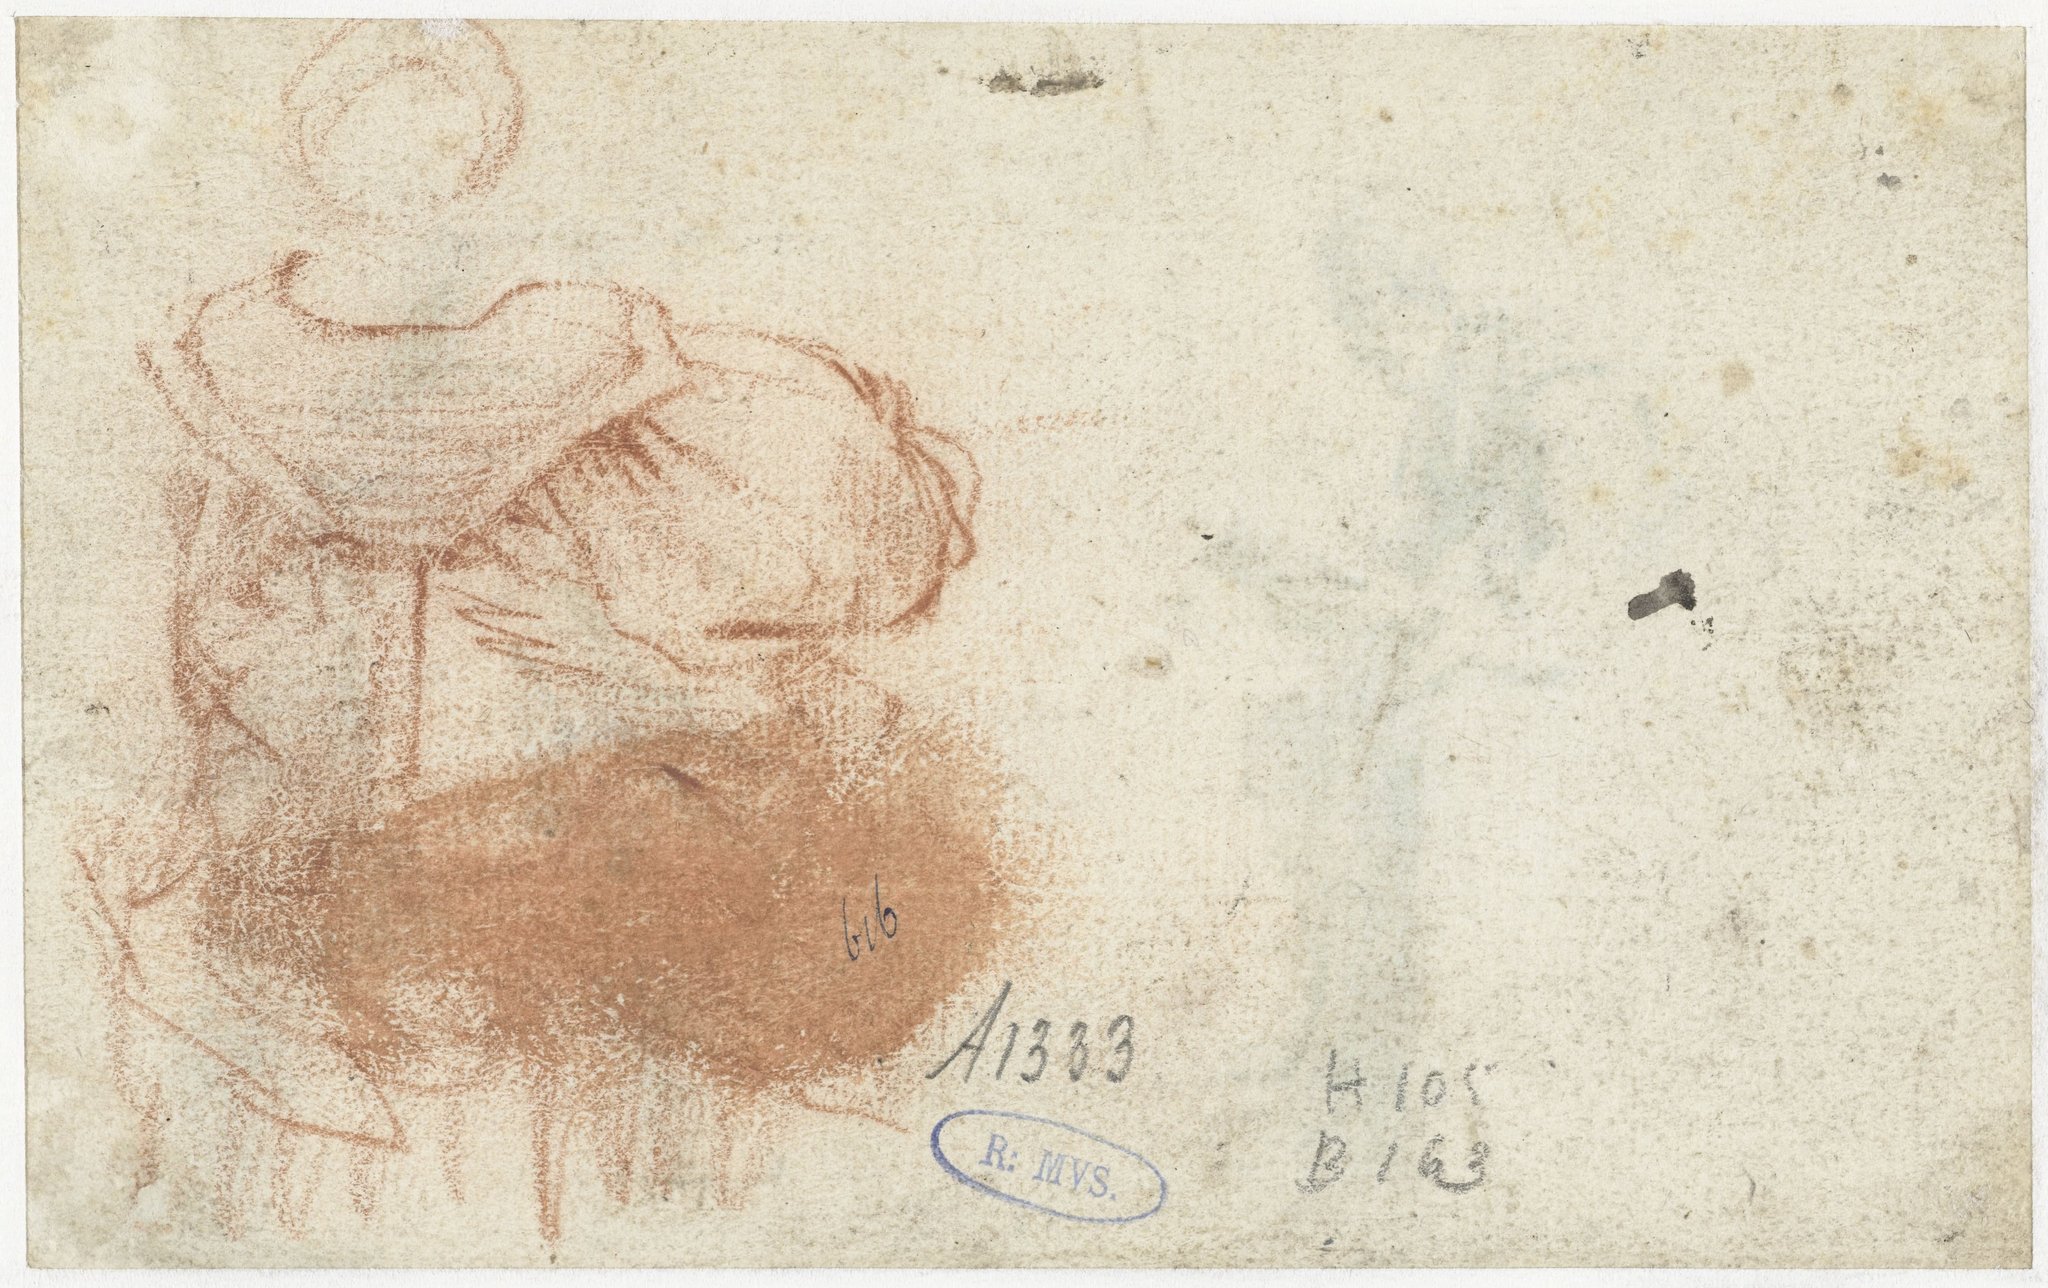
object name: drawing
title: Zittende vrouw, van achteren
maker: moses ter borch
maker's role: draughtsman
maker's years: 1645-1667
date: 1662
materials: chalk, paper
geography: zwolle